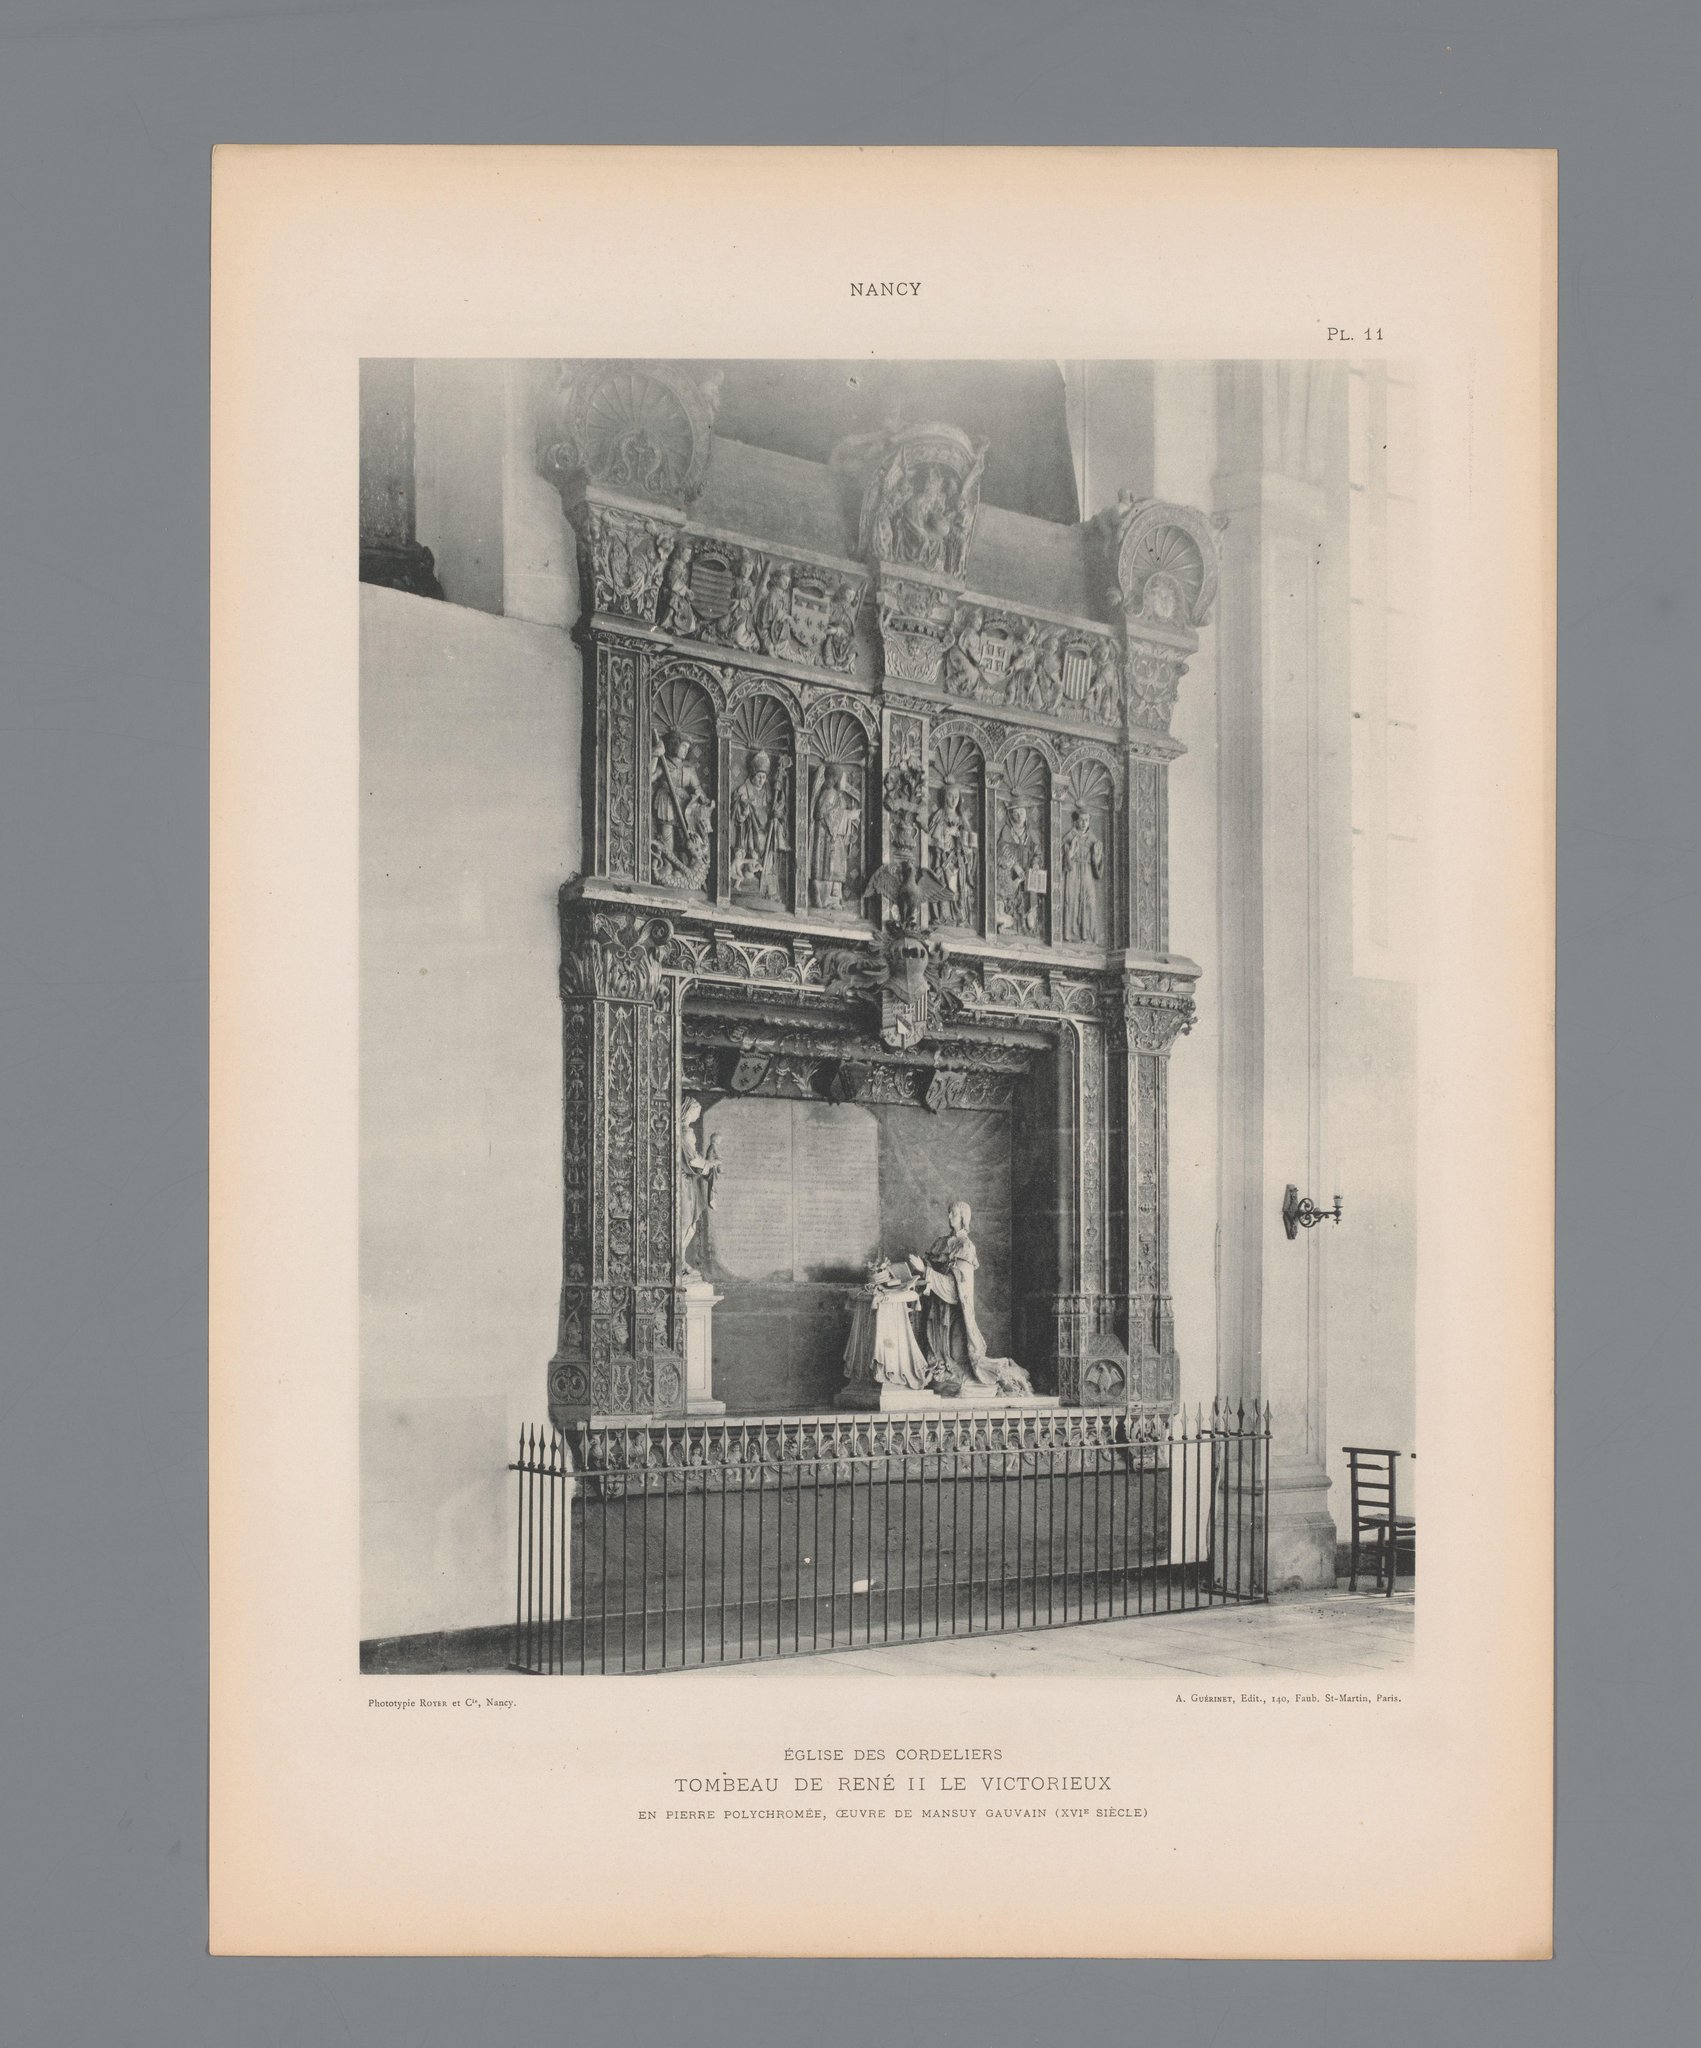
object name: photomechanical print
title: Grafmonument van René II van Lotharingen in de Église des Cordeliers te Nancy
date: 1891-1896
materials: paper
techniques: photograph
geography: nancy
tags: interior of church, grave-building, monumental tomb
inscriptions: inscription: ‘Tombeau de René II le Victorieux (...)’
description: Deze prent maakt deel uit van een omslag met 103 prenten op 101 bladen en een titelblad.